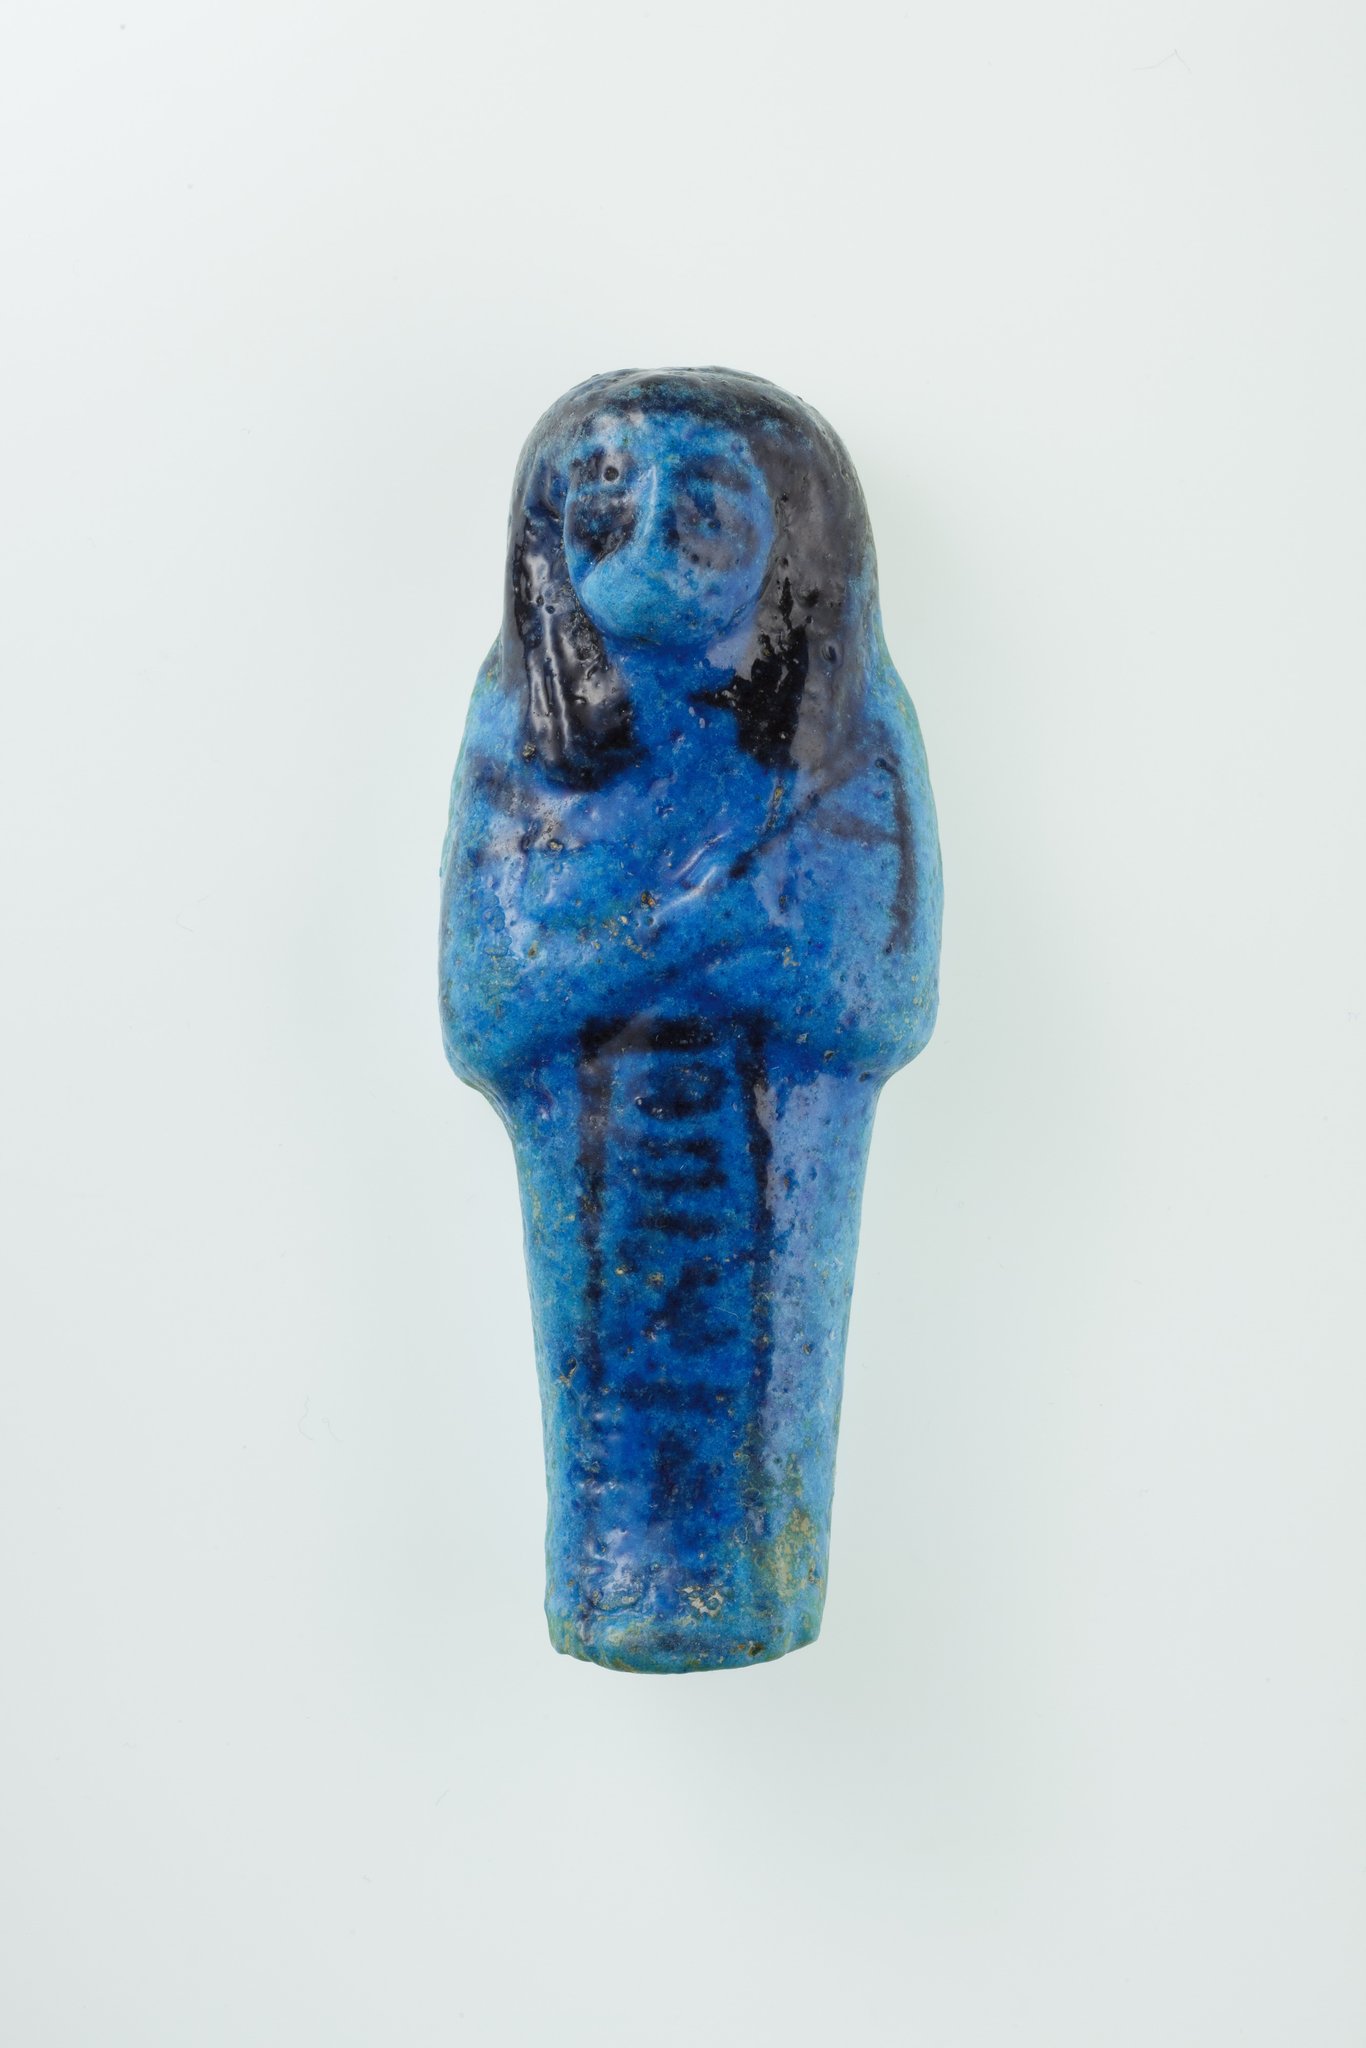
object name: shabti, worker, nauny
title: Worker Shabti of Nauny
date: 1050 BCE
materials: faience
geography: egypt